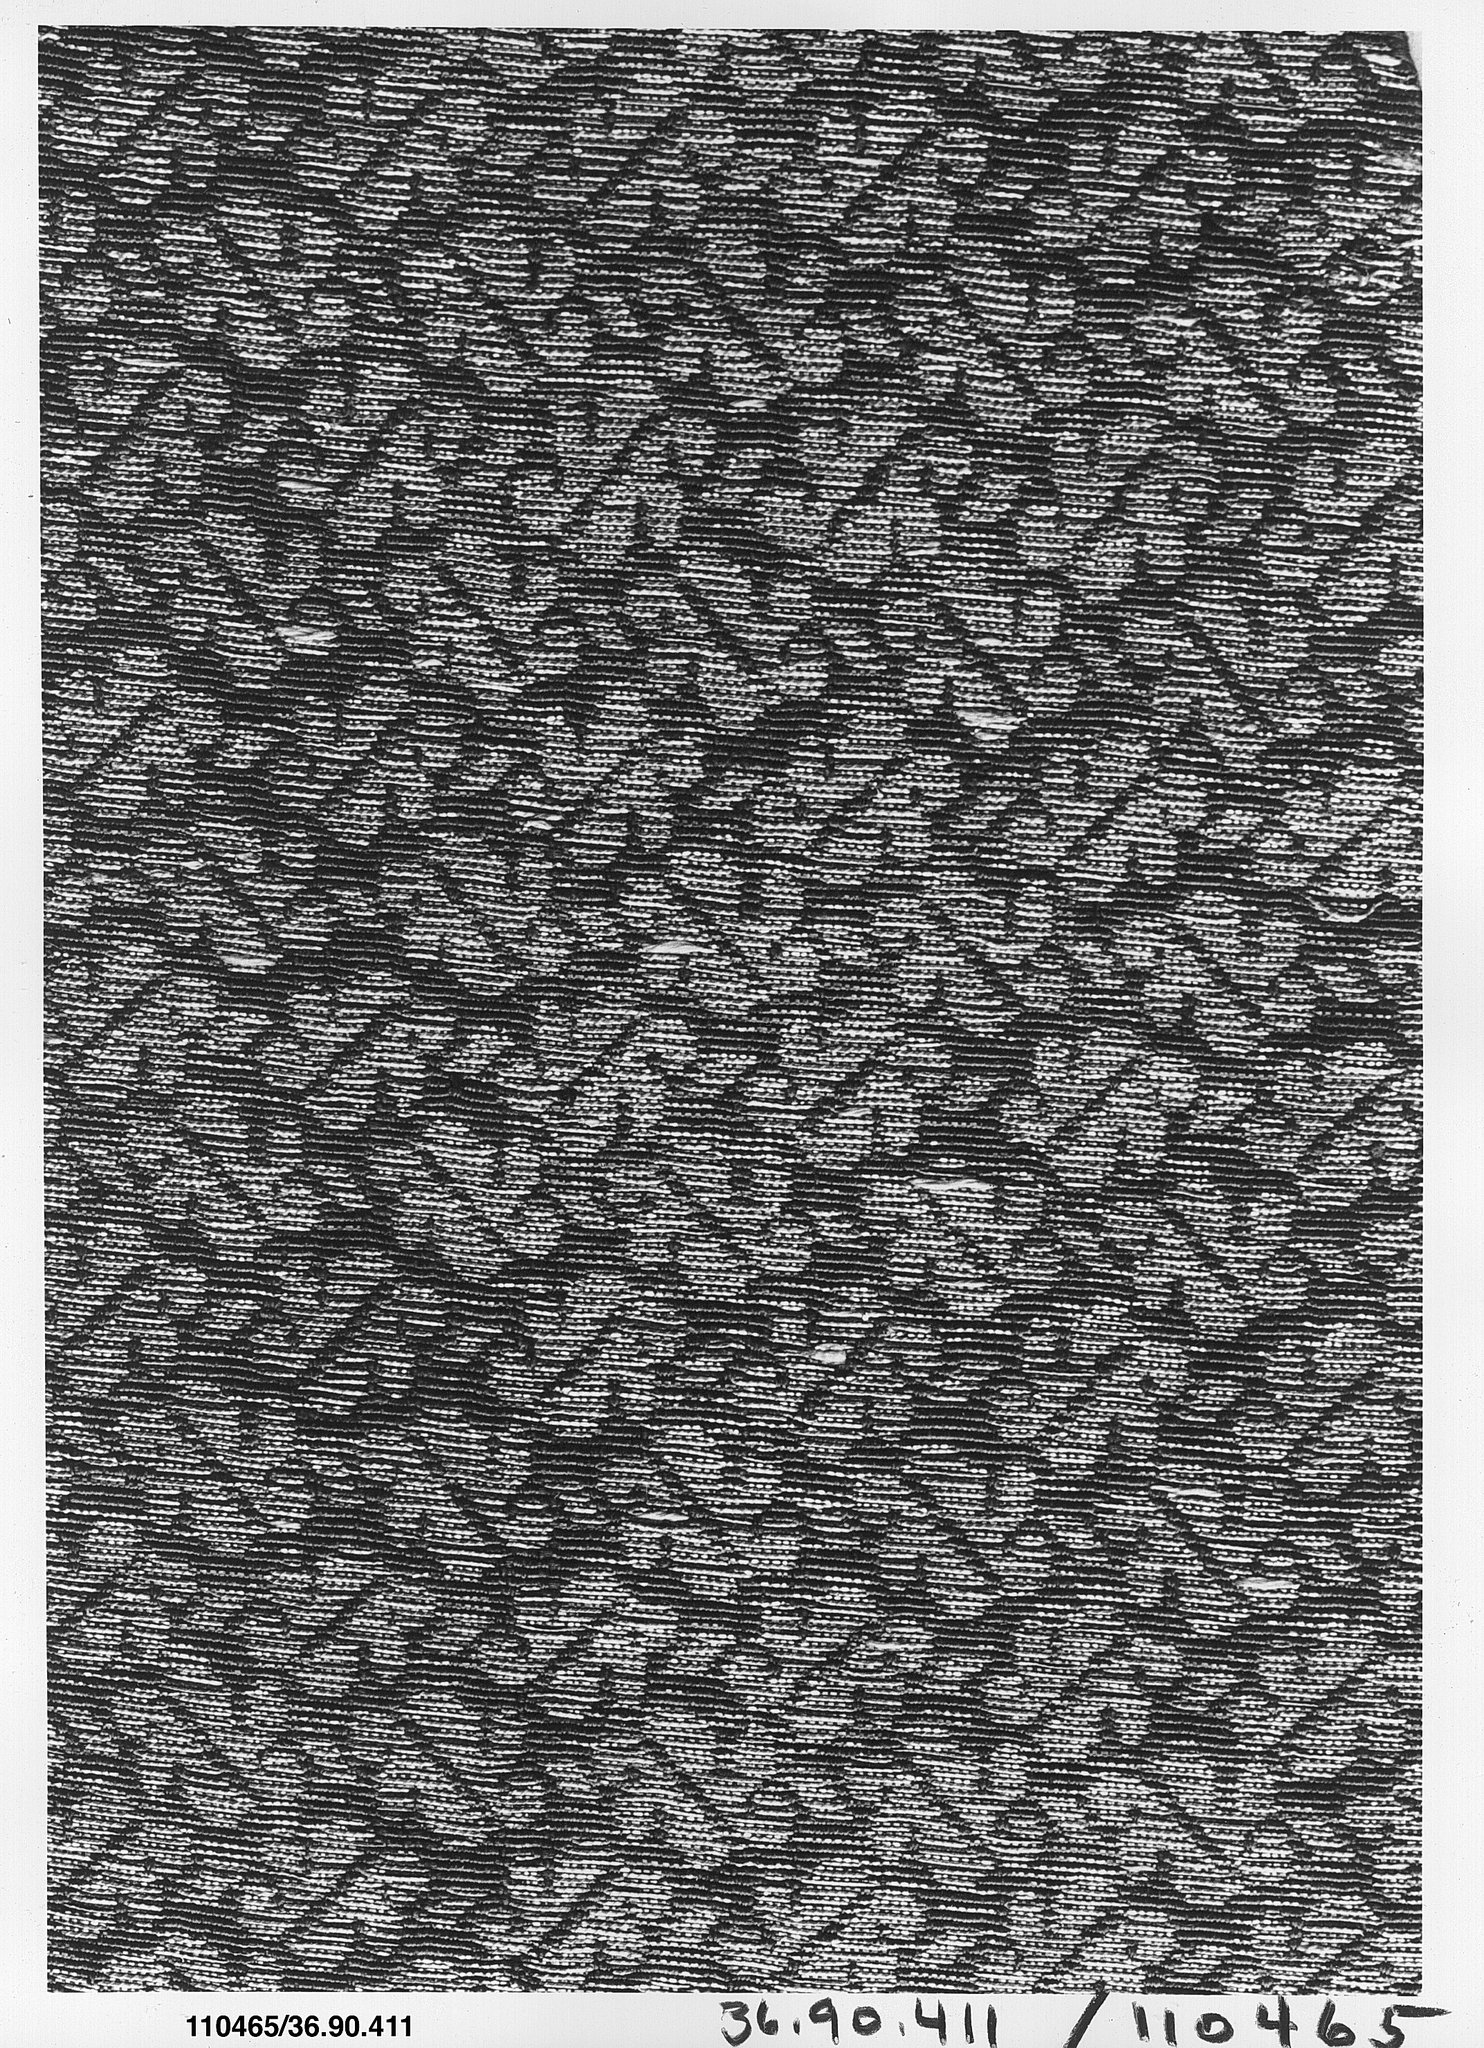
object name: piece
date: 1501-1700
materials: metal thread, silk